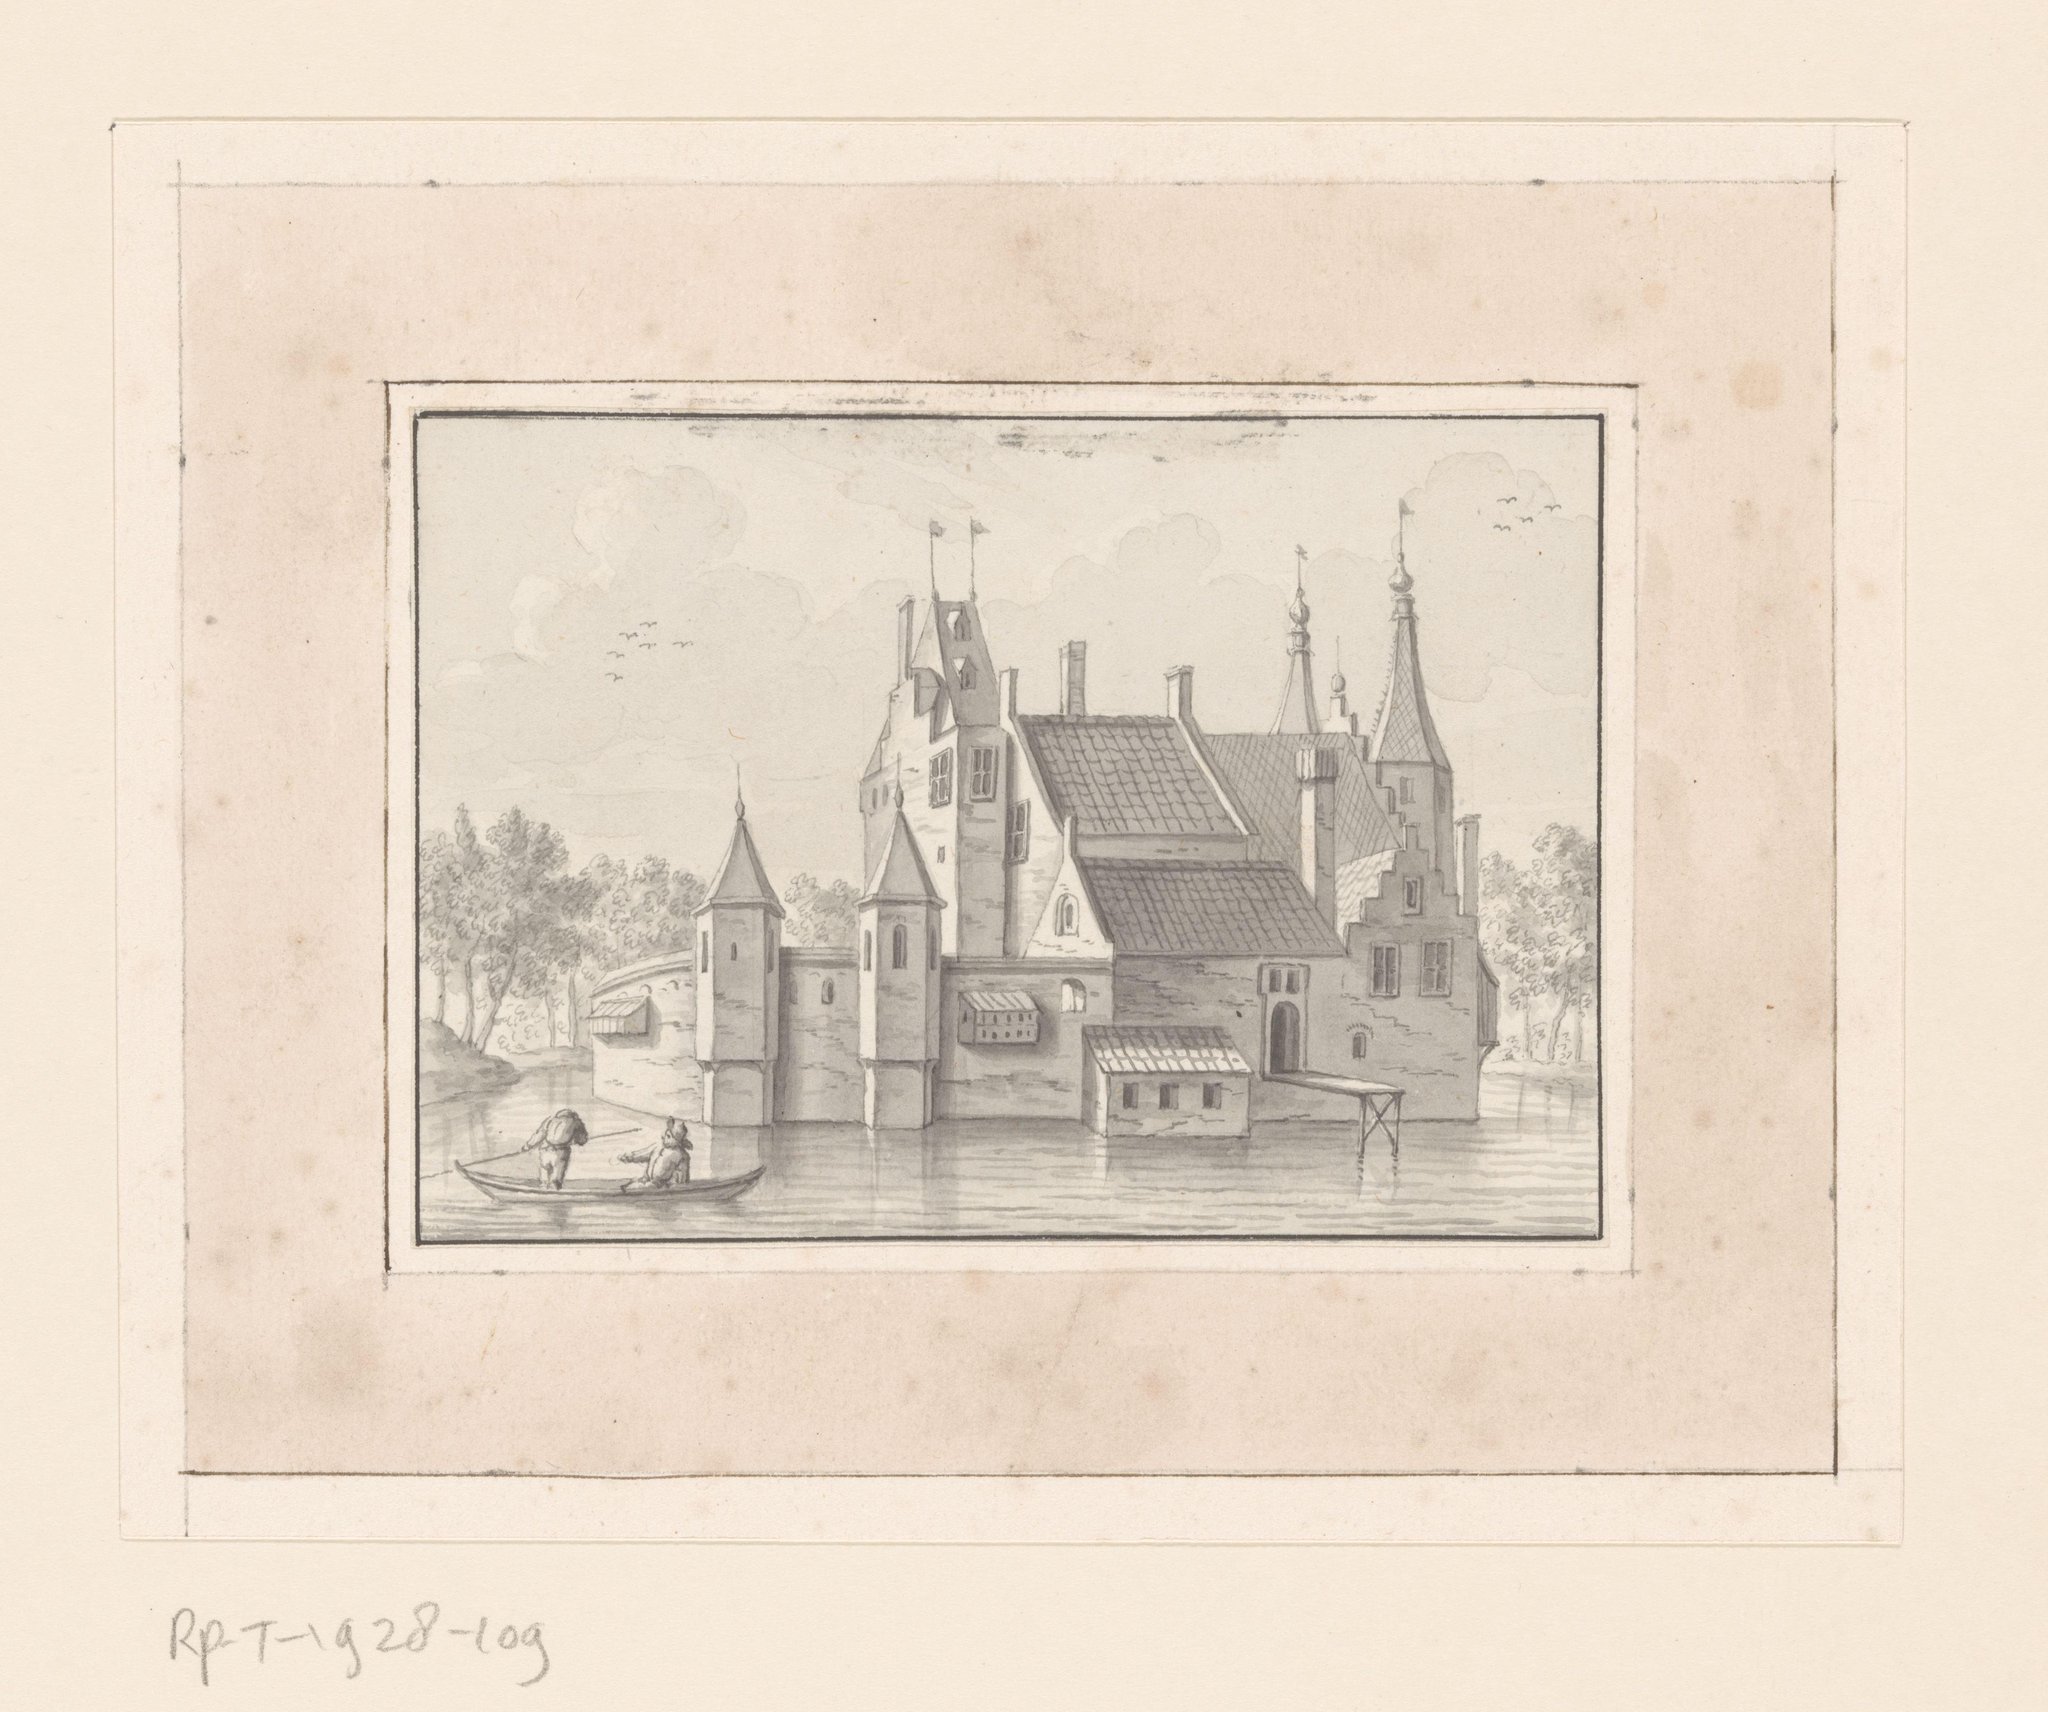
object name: drawing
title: Gezicht op Huis ter Does bij Leiderdorp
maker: Anonymous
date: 1727-1780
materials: ink, paper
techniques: brush, pen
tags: castle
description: Tekening naar de prent van Abraham Rademaker, zie RP-P-OB-73.447.